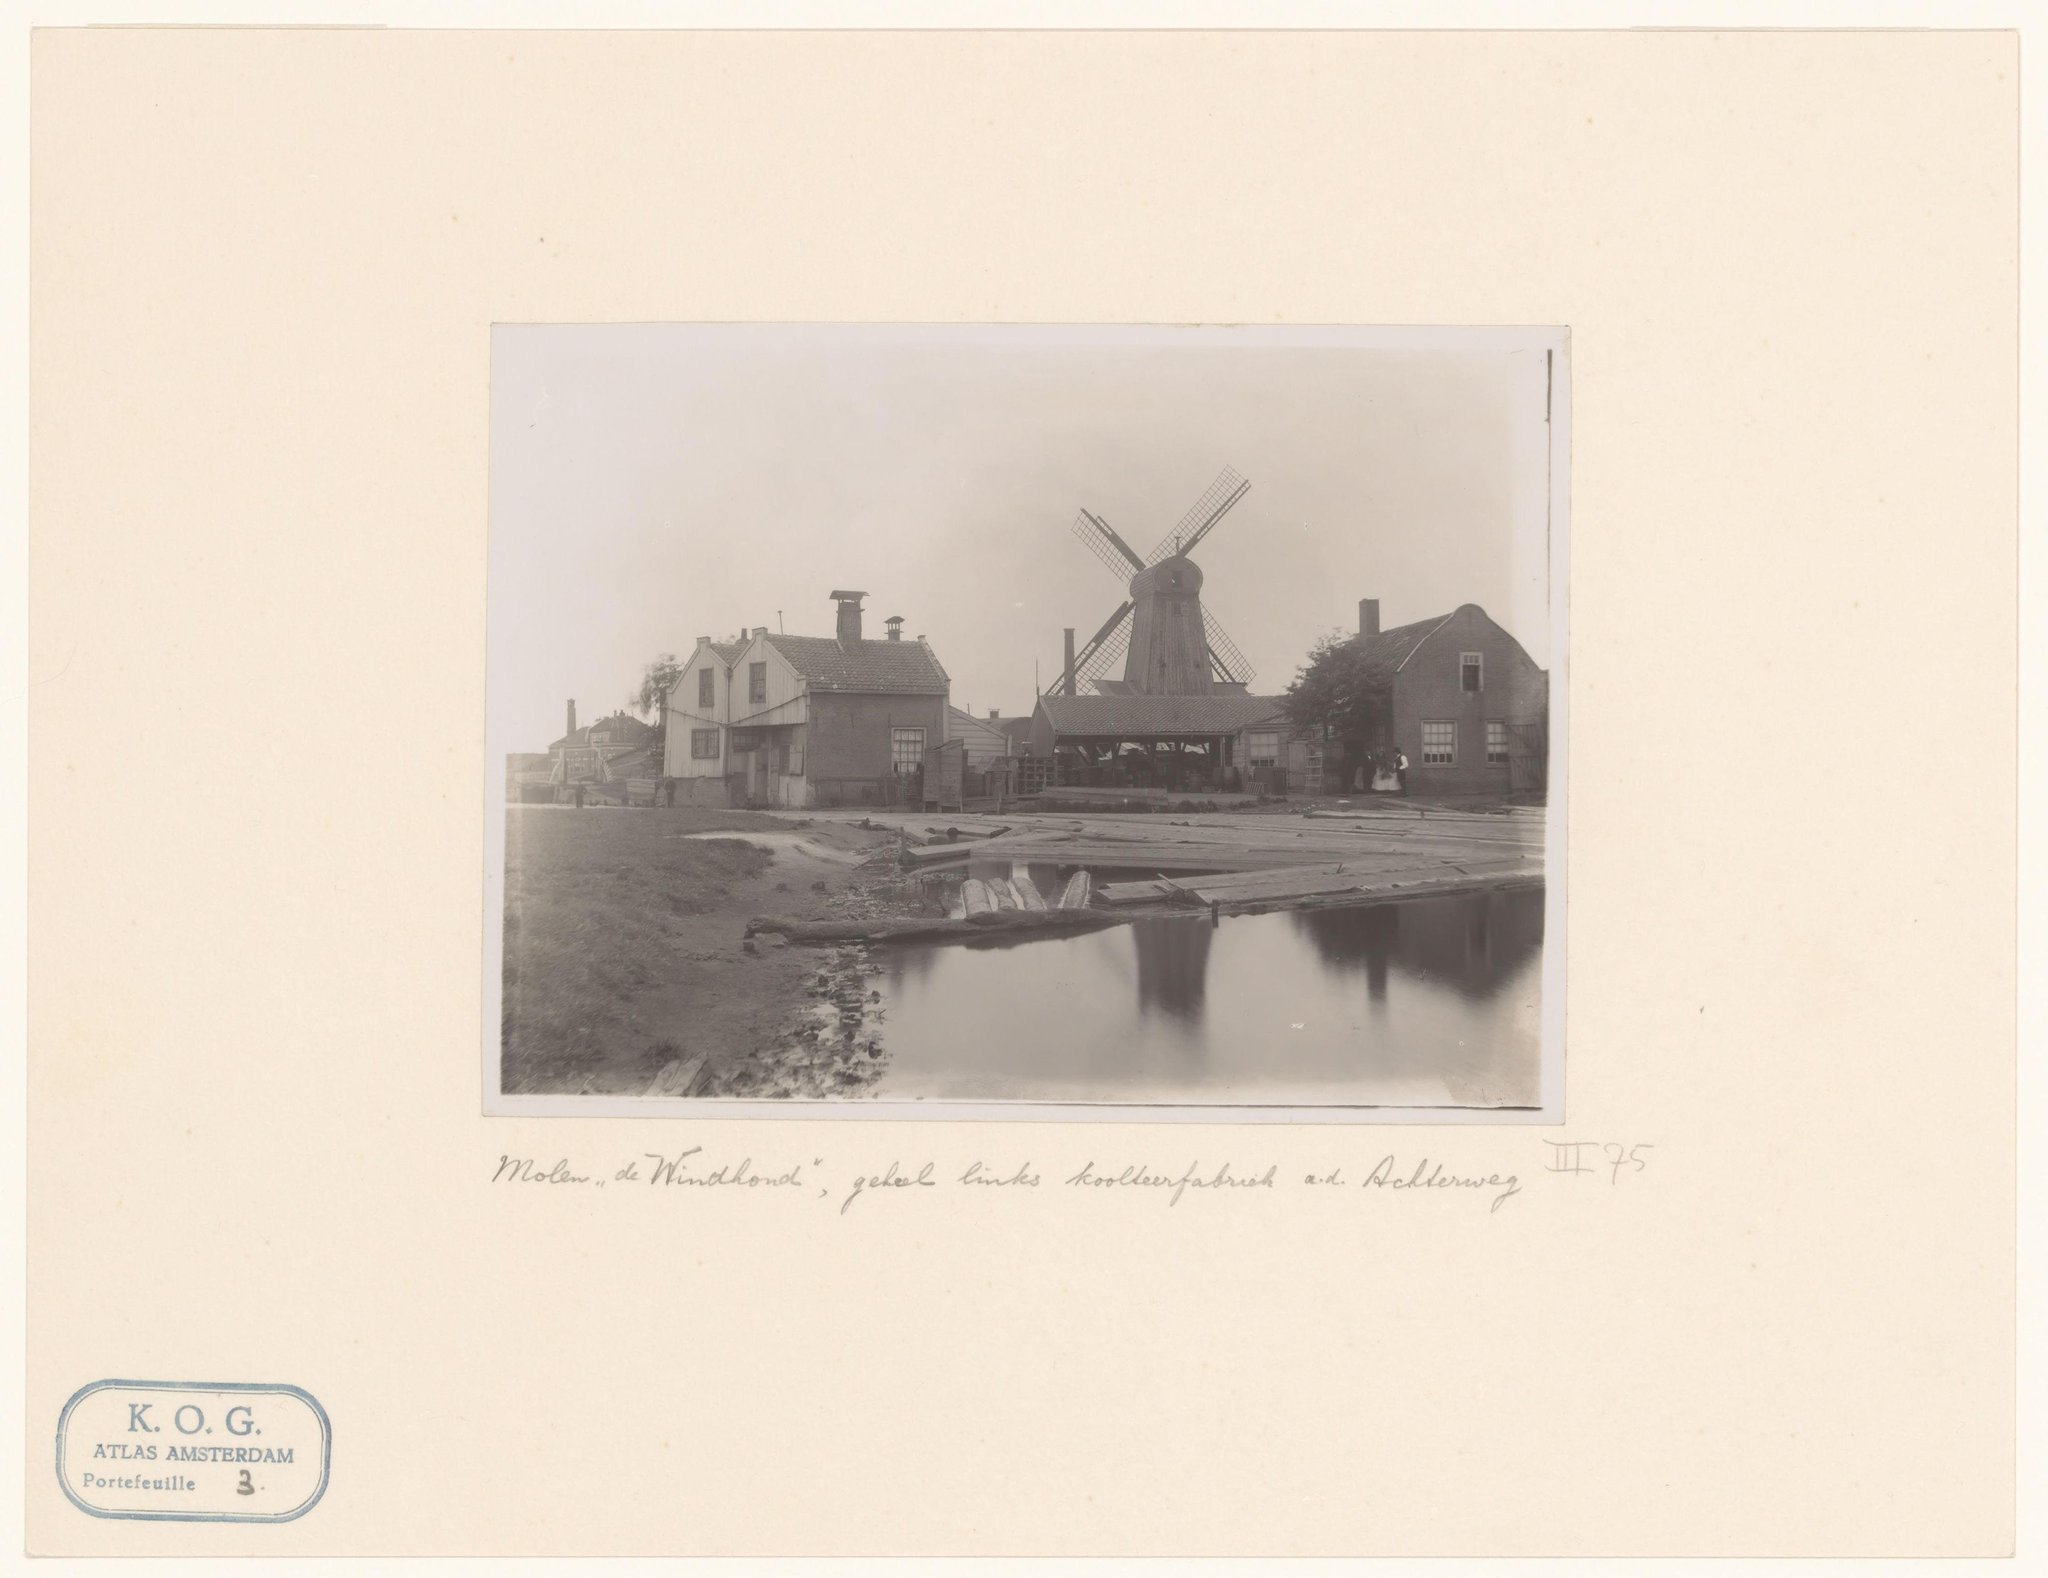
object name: photograph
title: Gezicht op molen De Windhond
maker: Anonymous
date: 1880-1897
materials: paper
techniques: gelatin silver print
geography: amsterdam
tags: city-view in general; 'veduta', windmill in landscape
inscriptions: collector's mark: ‘3.’ Lugt 1641b, inscription: ‘Molen "de Windhond", geheel links koolteerfabriek a.d. Achterweg’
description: Onderwerpsrubriek binnen de Atlas Amsterdam: Achterburgwal, Nieuwezijds en - Oudezijds; Nieuwe Achtergracht, Achterweg, Akoleienstraat.